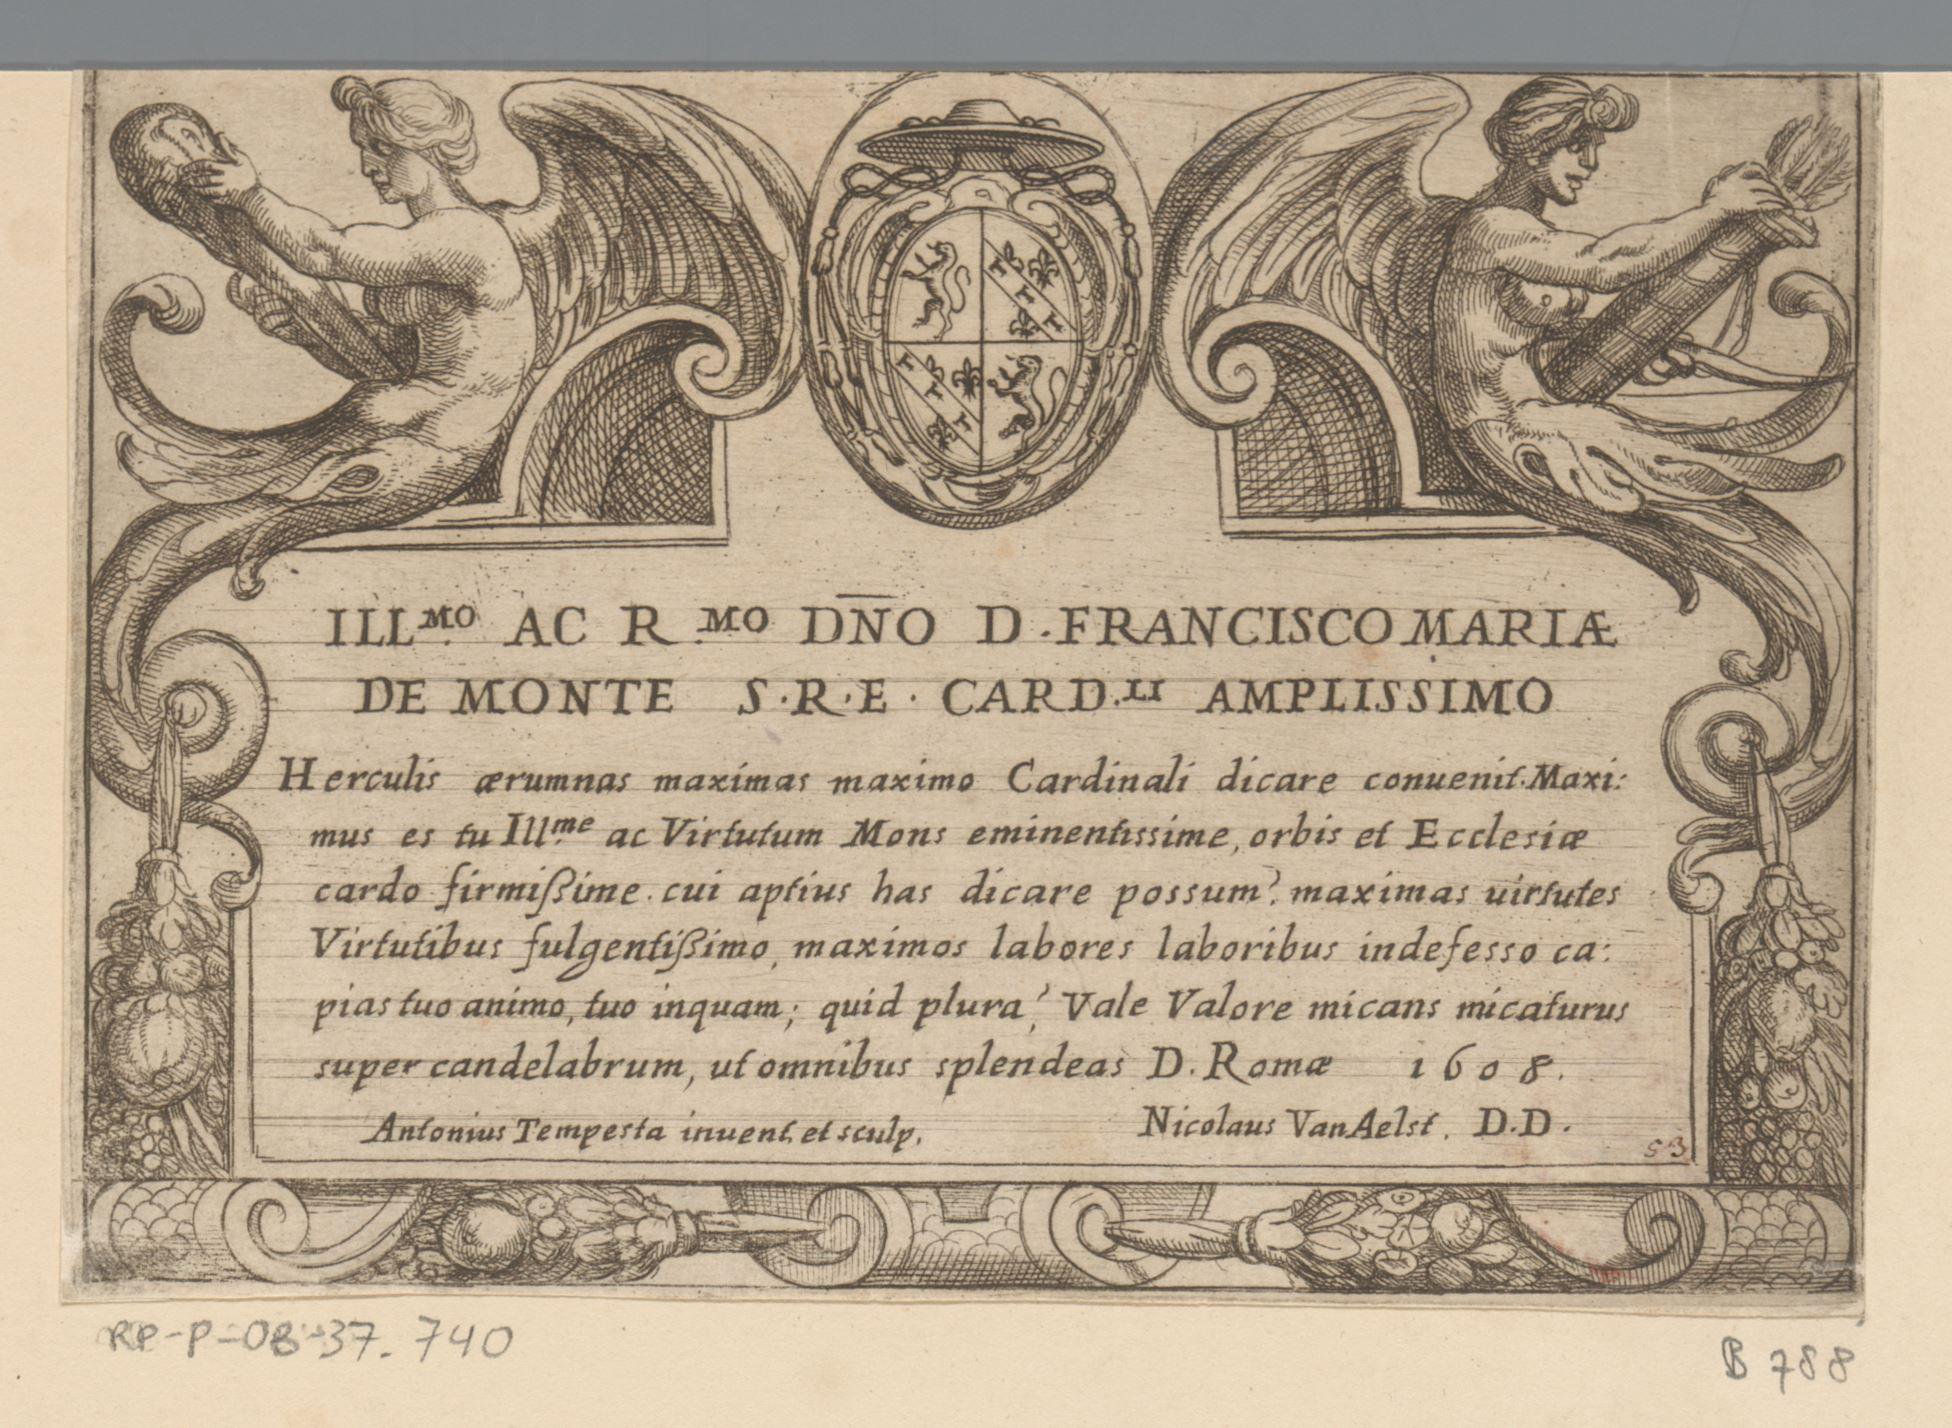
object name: print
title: Cartouche met gevleugelde figuren, guirlandes en opdracht aan kardinaal Bourbon del Monte Santa Maria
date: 1608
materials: paper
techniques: etching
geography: rome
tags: ornament ~ cartouche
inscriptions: collector's mark: Lugt 240, number: ‘53’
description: Opdracht bij een reeks van 12 prenten met de twaalf werken van Hercules.